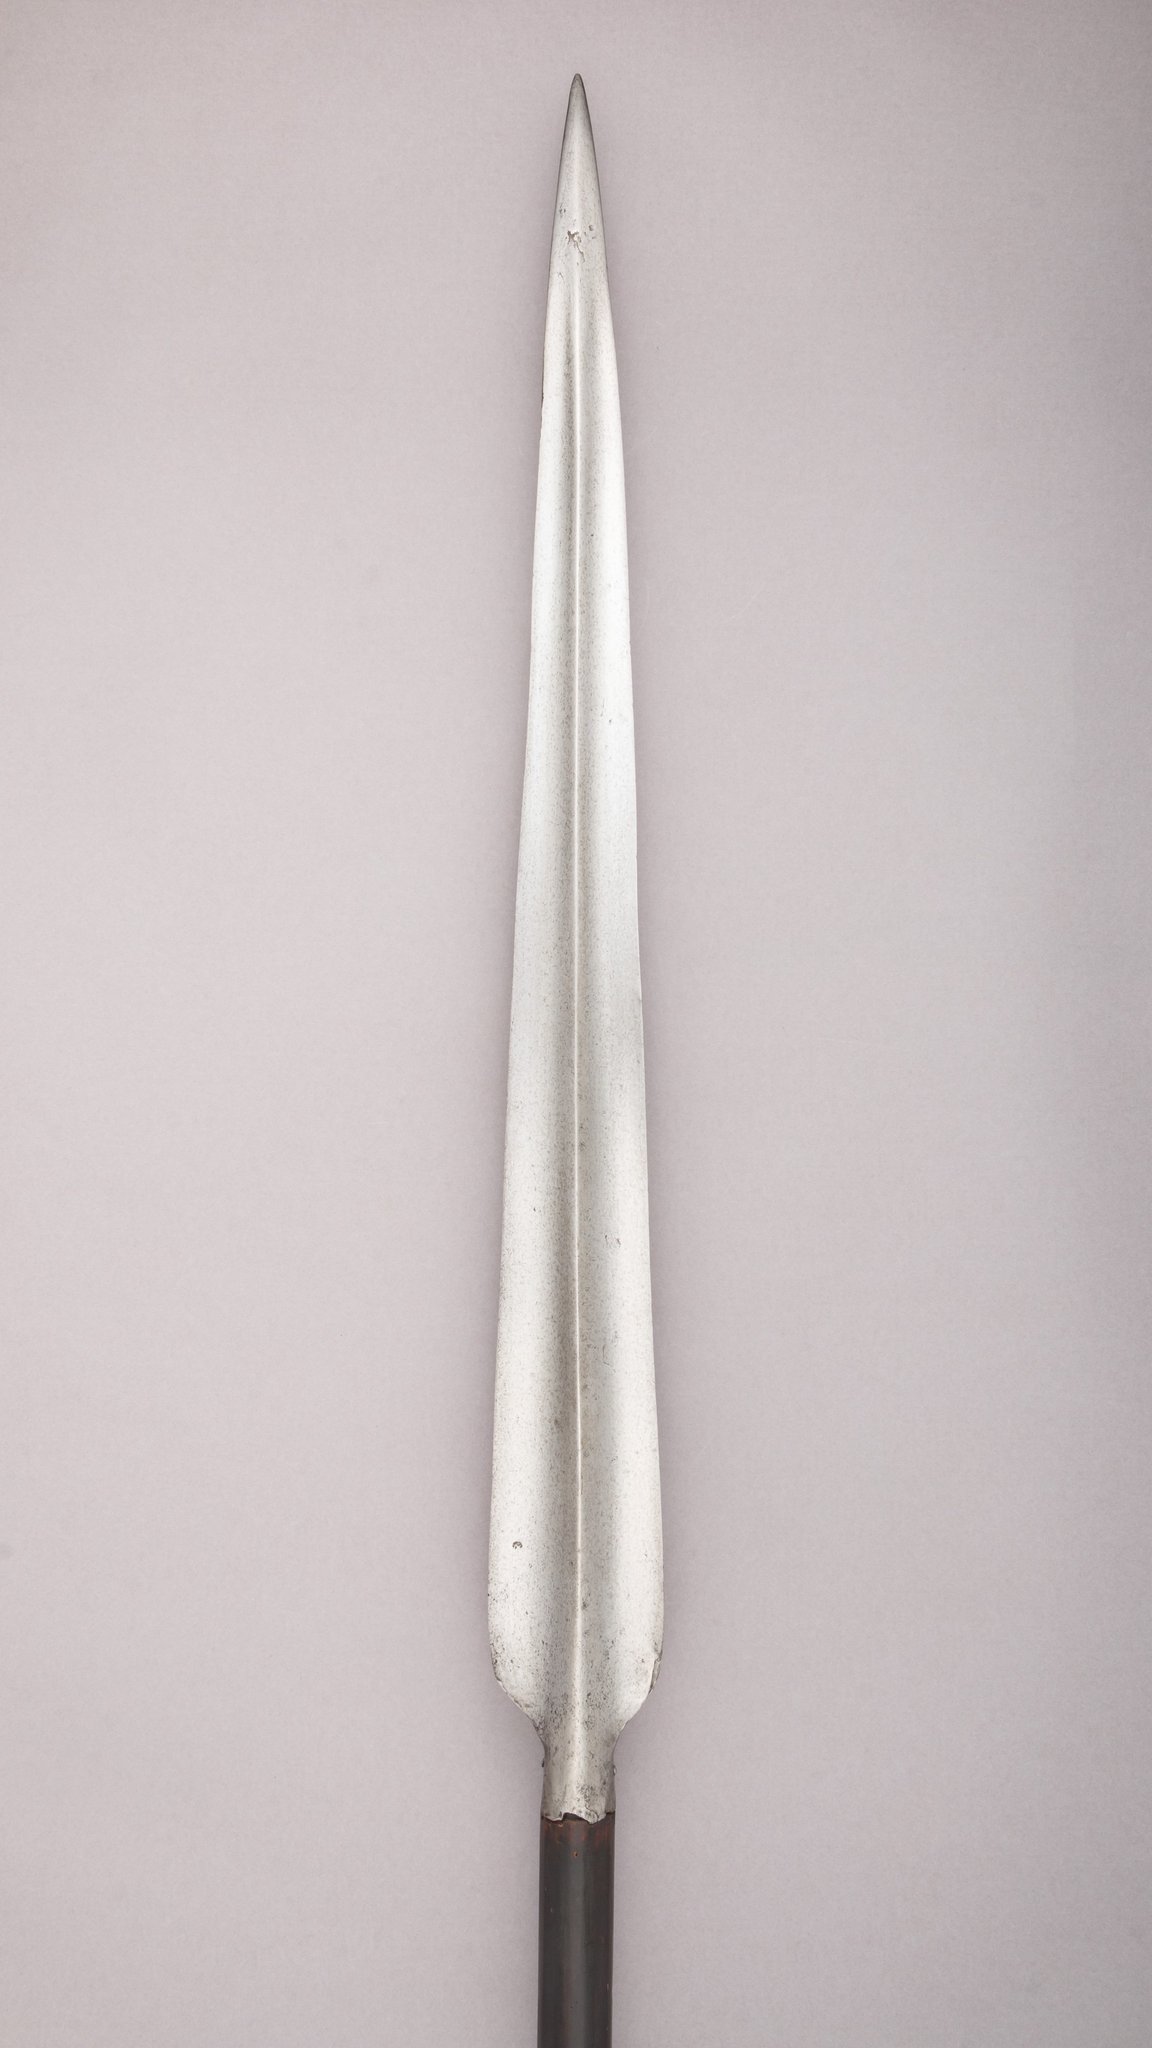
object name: lance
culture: italian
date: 1401-1500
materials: steel, wood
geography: italy